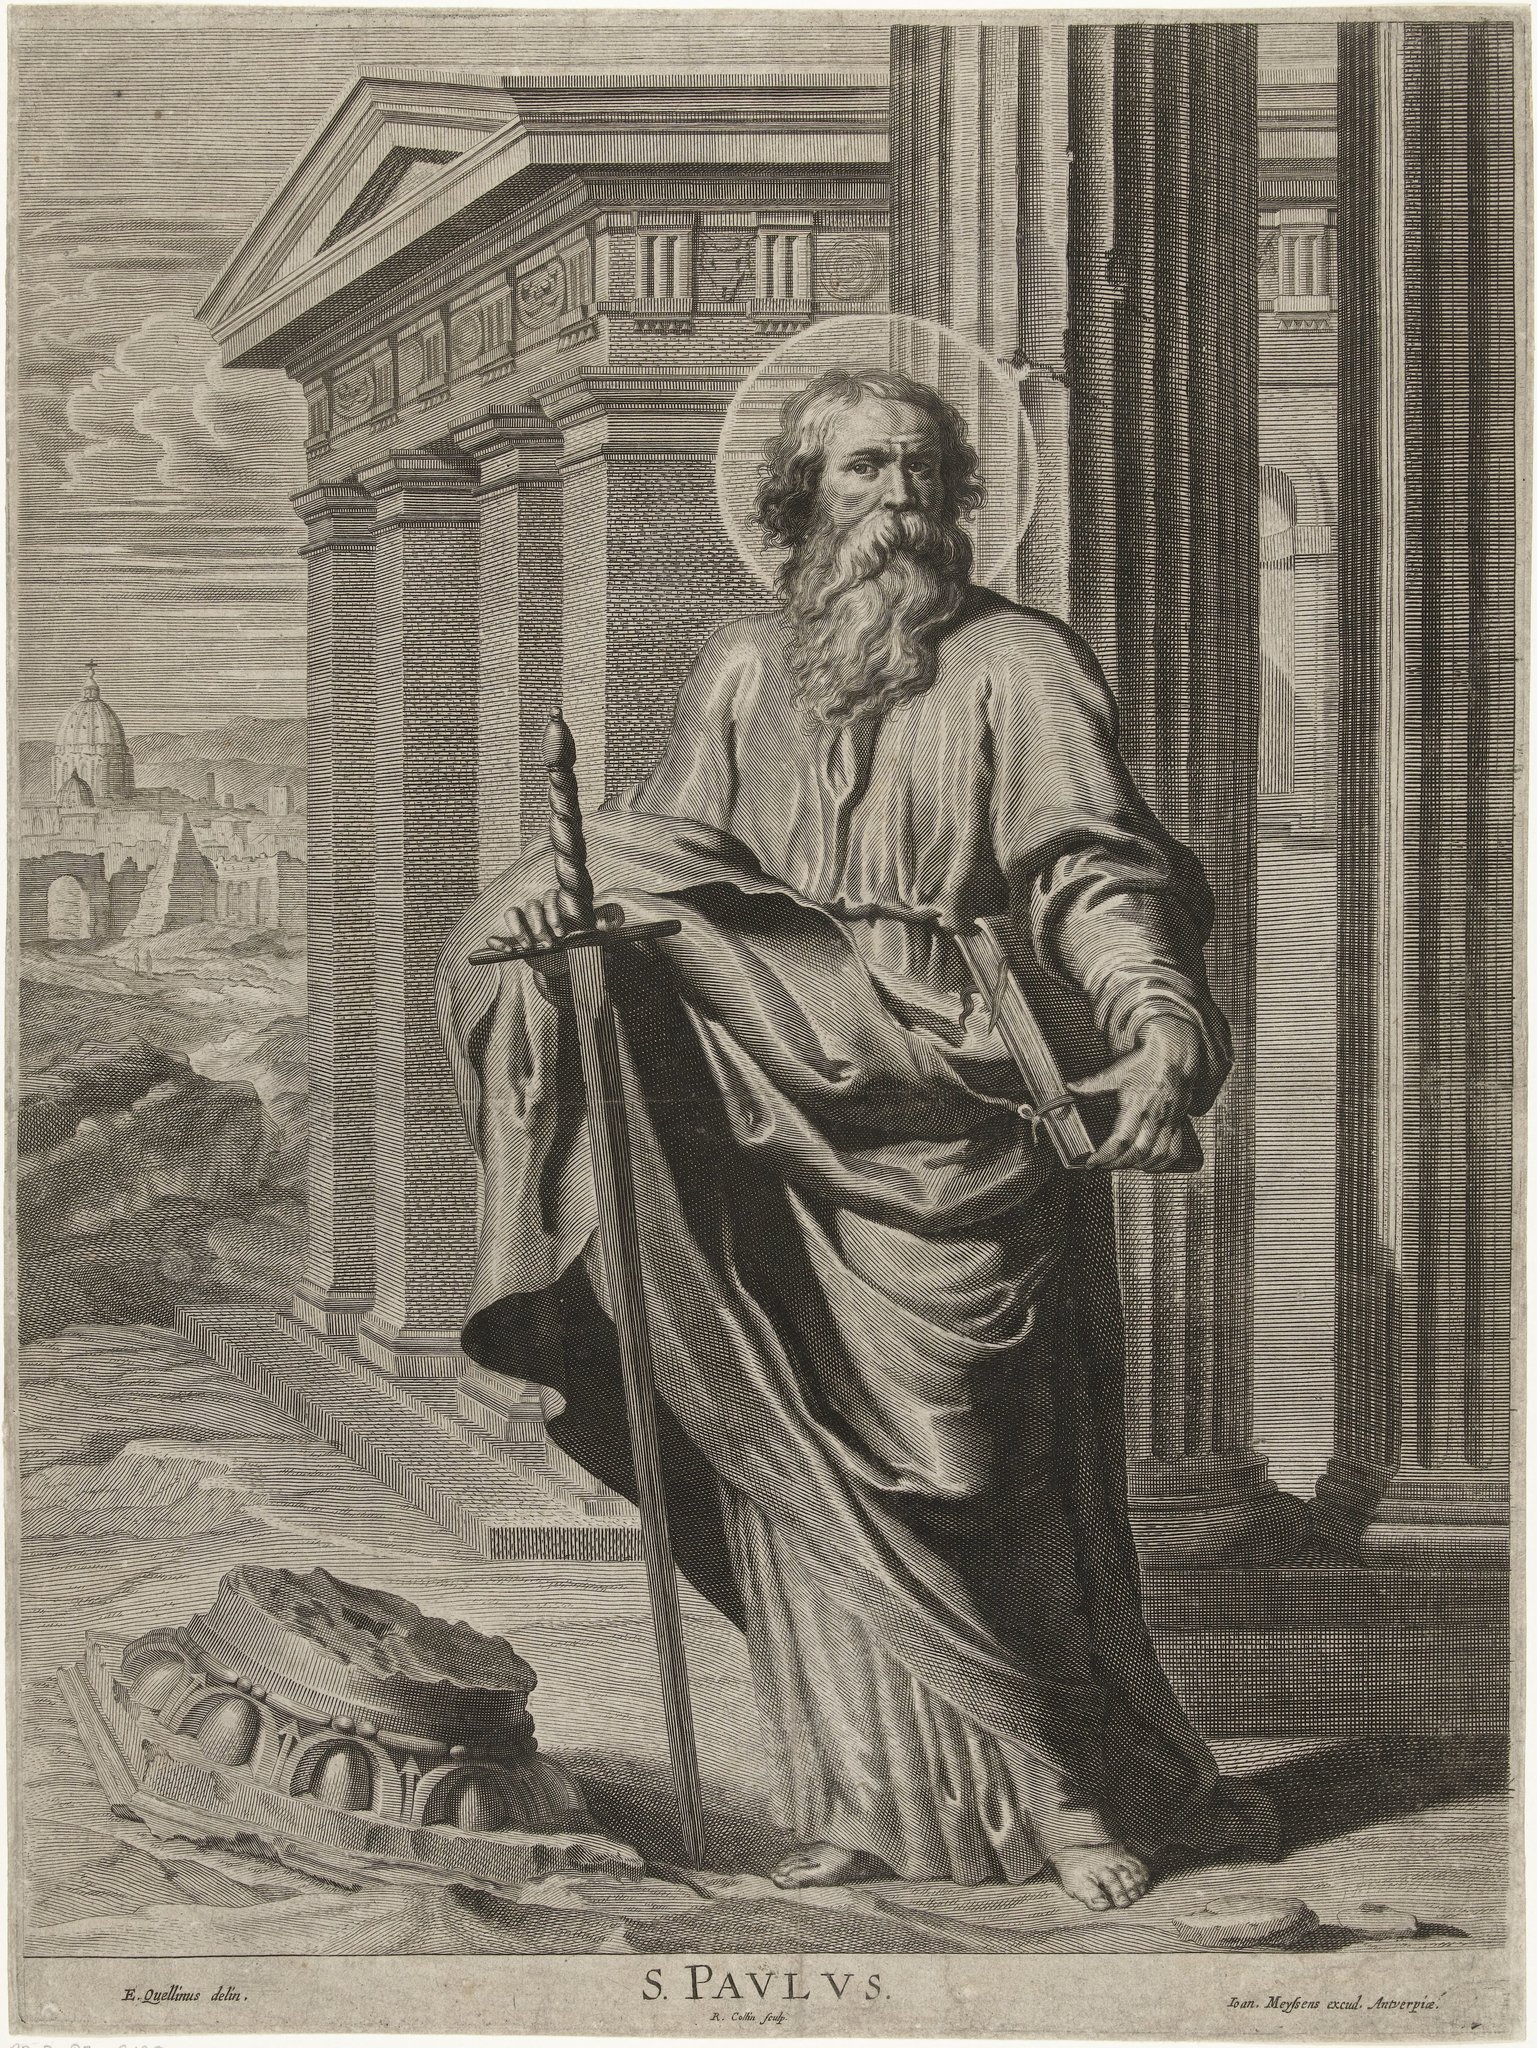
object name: print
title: S. Paulus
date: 1650-1670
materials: paper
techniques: engraving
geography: antwerp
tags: the apostle paul of tarsus; possible attributes: book, scroll, sword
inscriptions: collector's mark: Lugt 240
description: De apostel Paulus met zwaard en boek. Hij staat tussen ruïnes van een Romeinse tempel. Op de achtergrond links de stad Rome.